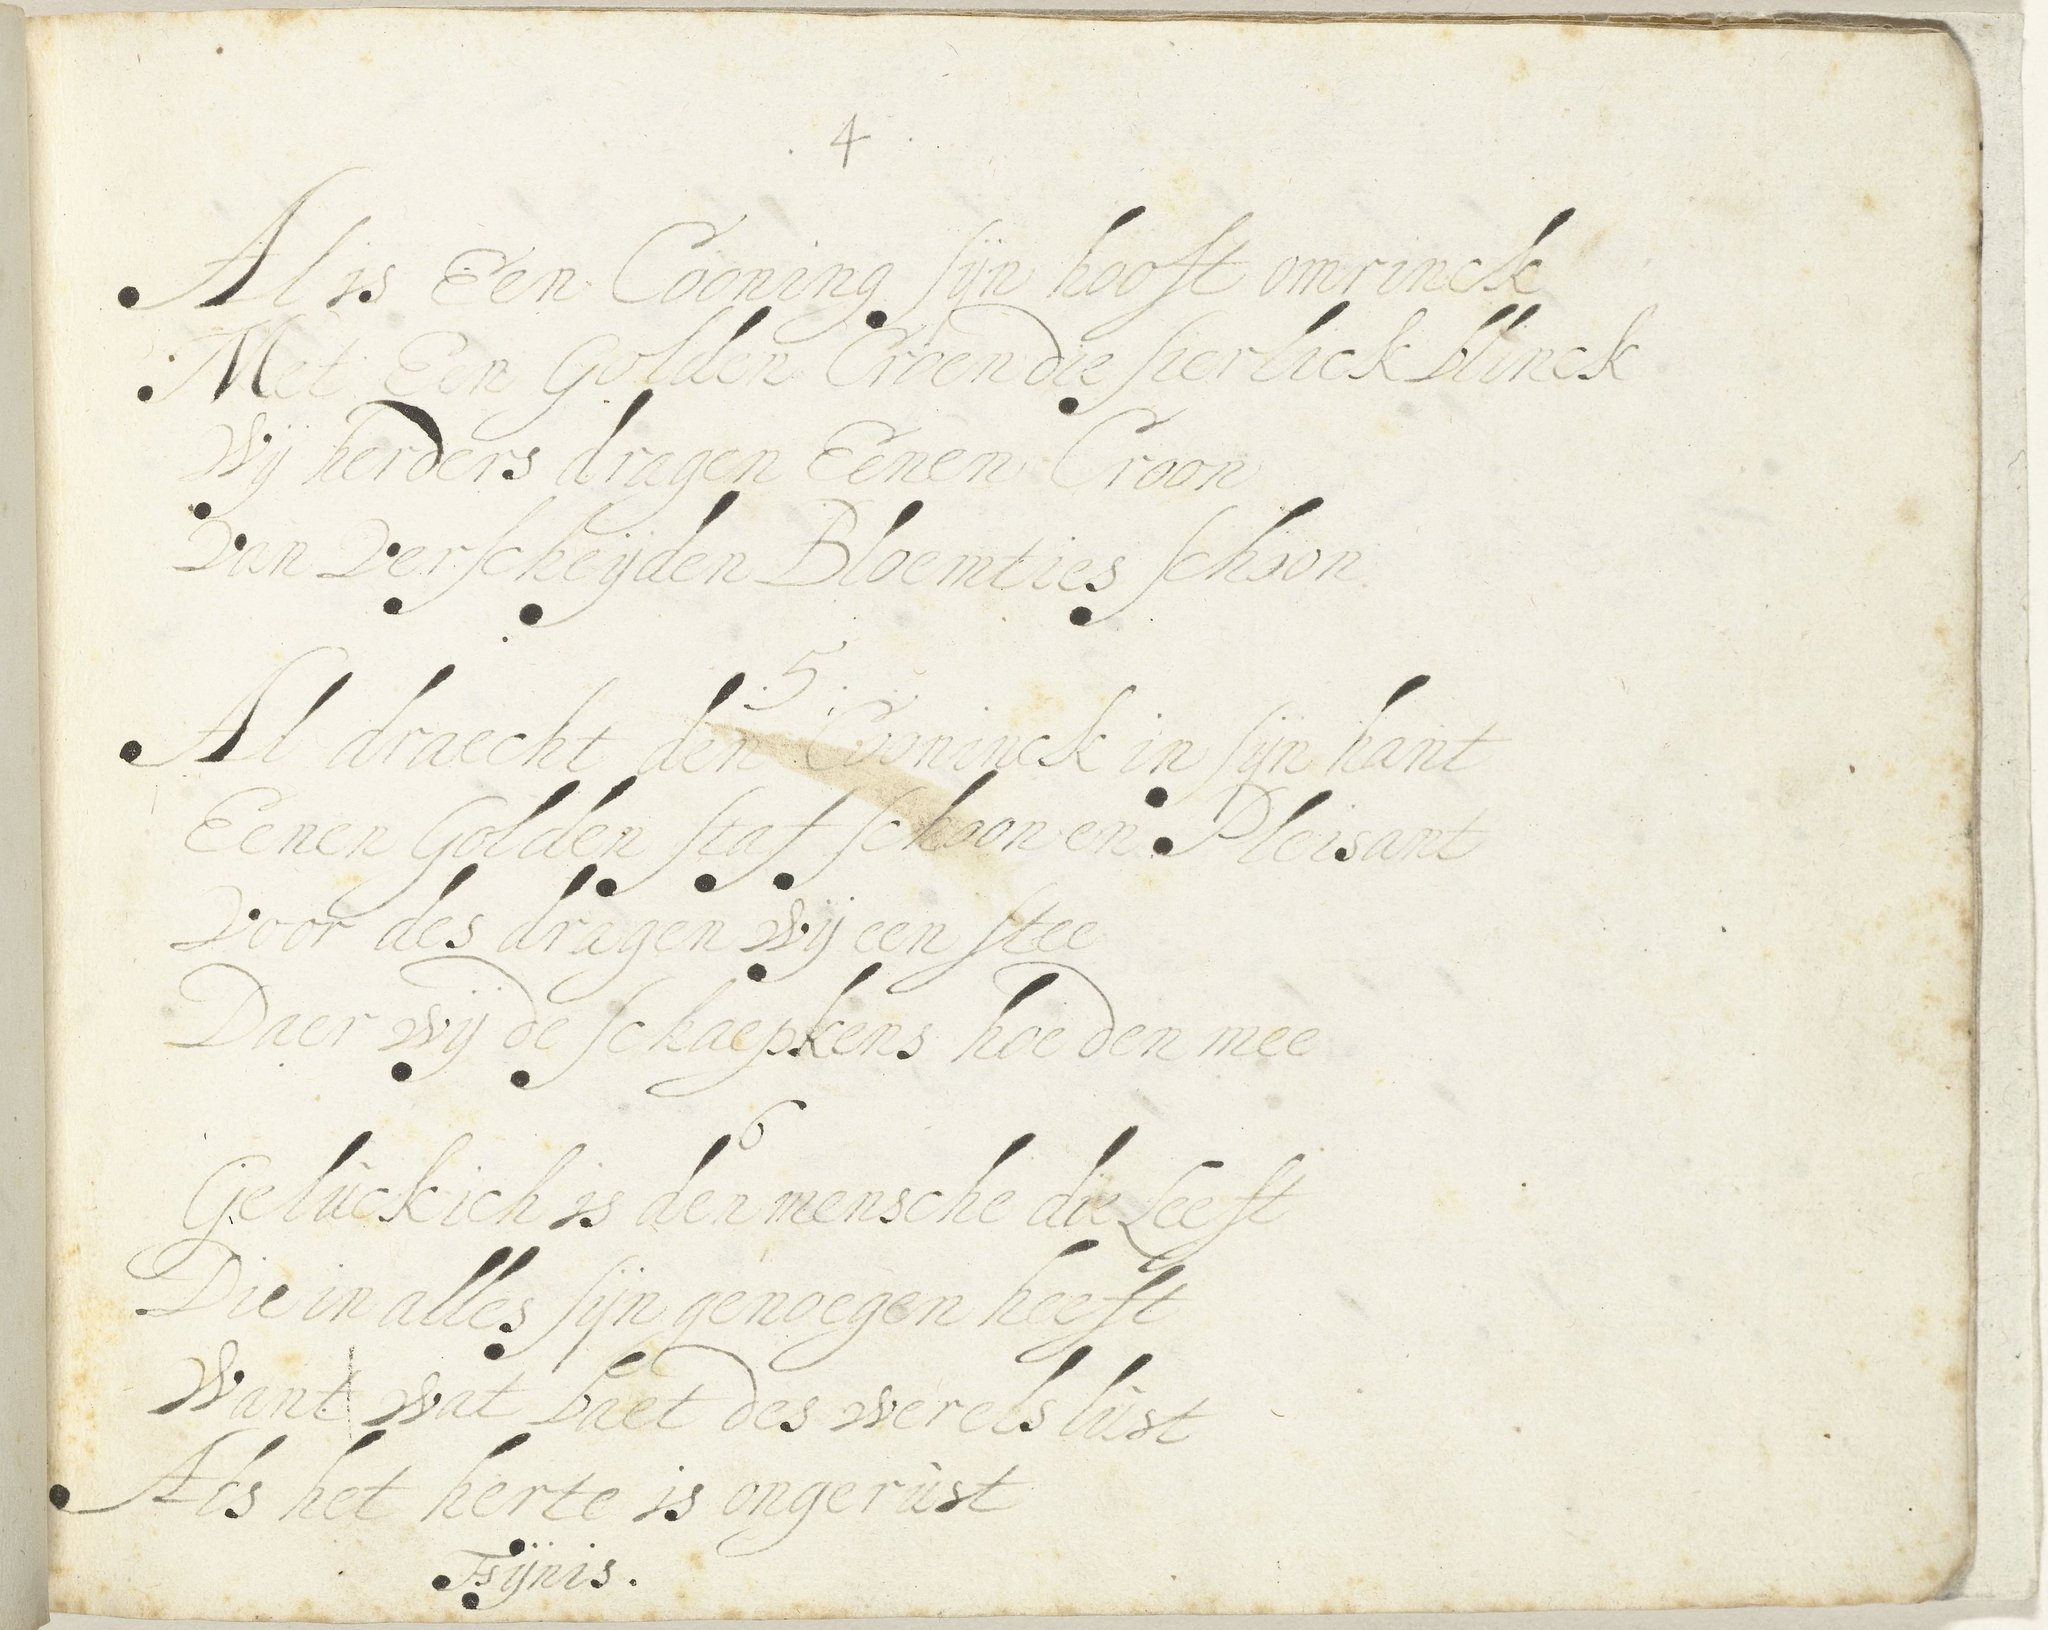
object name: poem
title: Pastorale (deel 2)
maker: gesina ter borch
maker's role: draughtsman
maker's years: 1633-1690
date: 1650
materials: ink, paper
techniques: calligraphy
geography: zwolle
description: Vervolg van het gedicht op de vorige pagina (verso van folio 21) over het contrast tussen de luxe aan het hof en de eenvoud van het herdersleven.